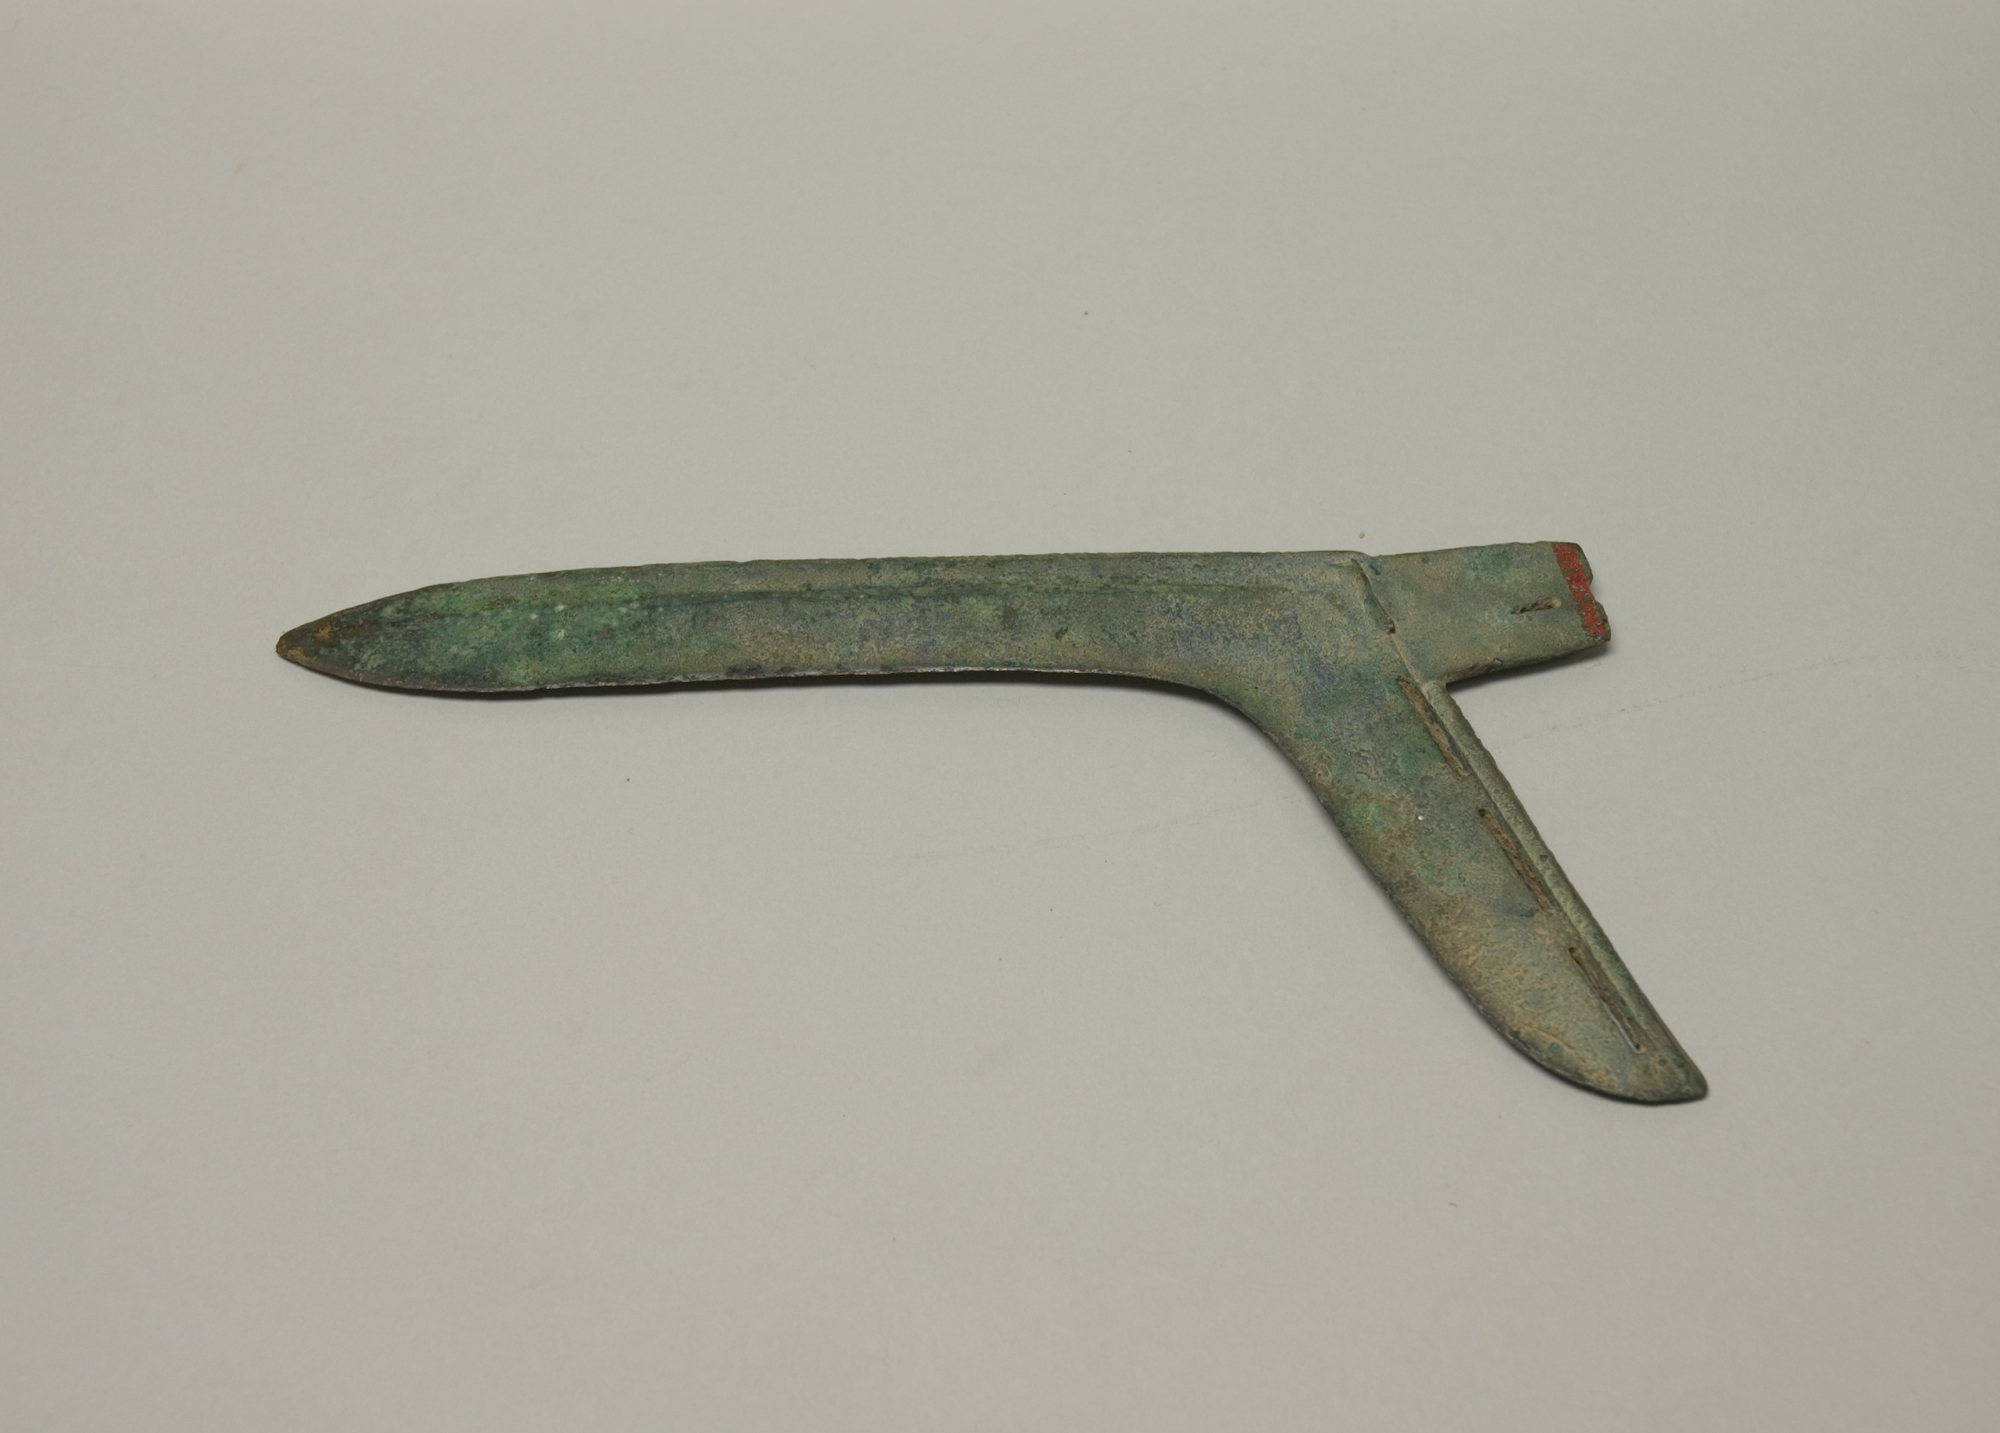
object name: ax blade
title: Eccentric Ax Blade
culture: vietnamese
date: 500 BCE-300 CE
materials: bronze